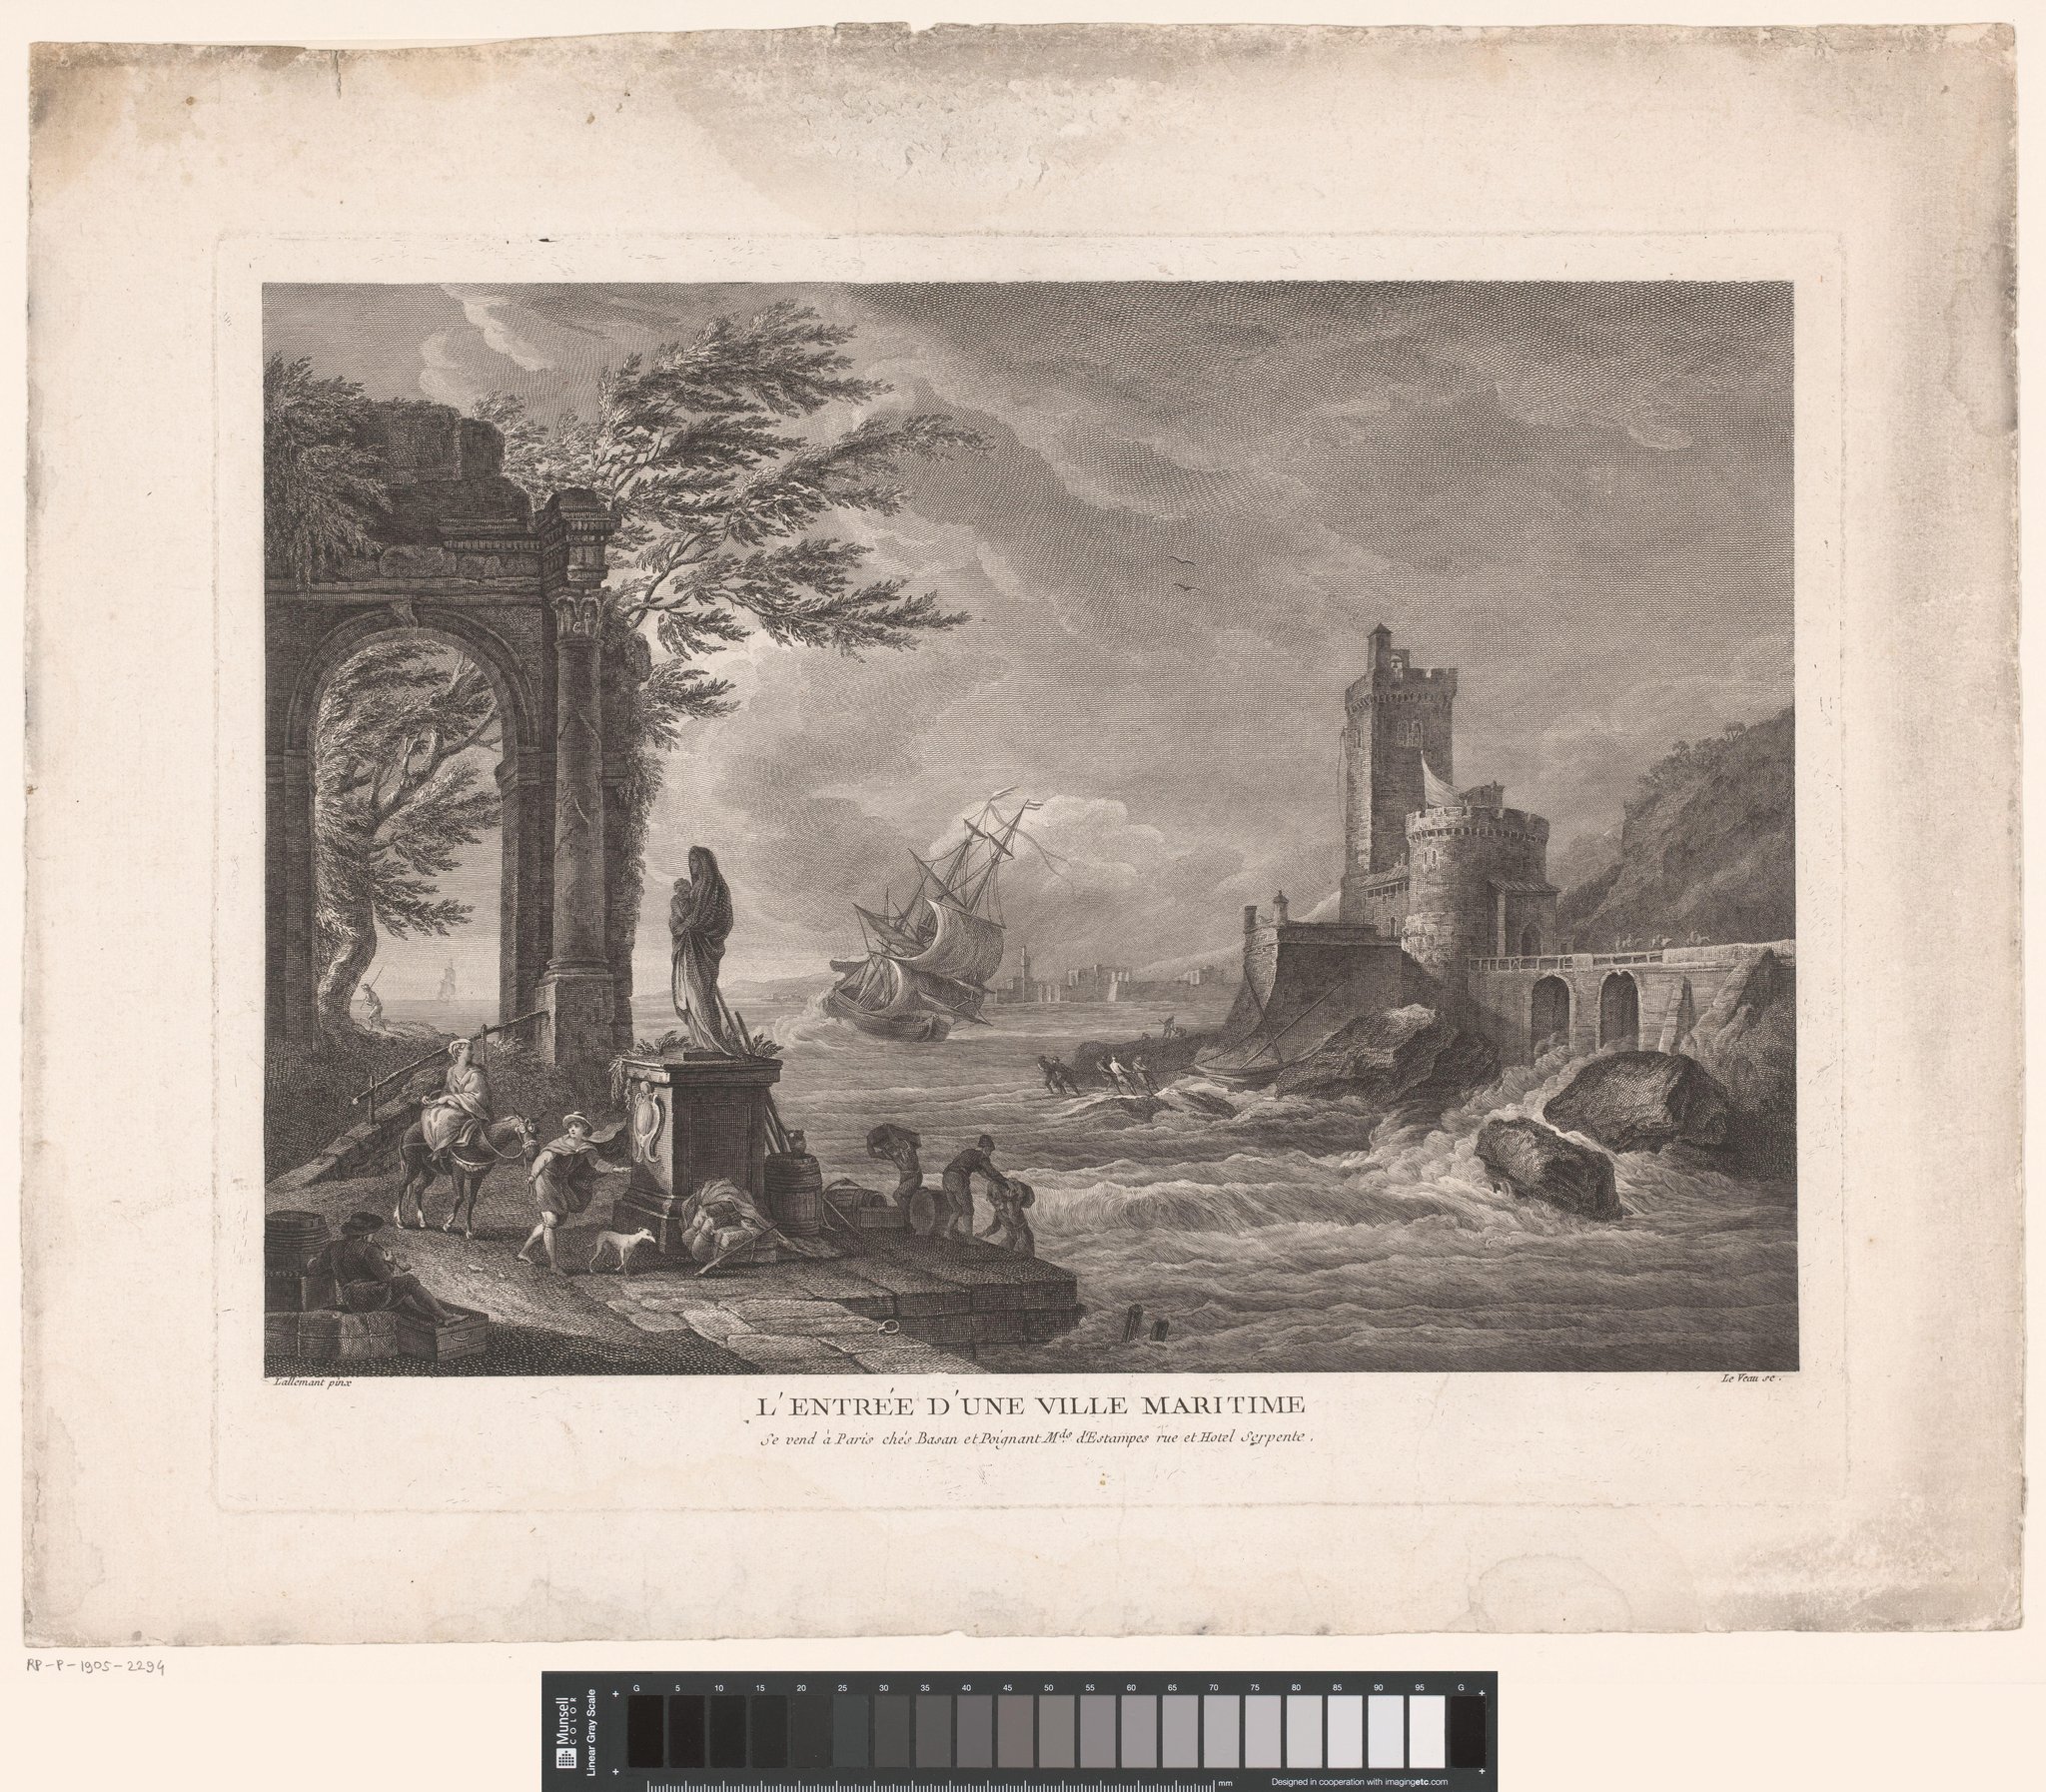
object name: print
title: L'entrée d'une ville maritime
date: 1739-1786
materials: paper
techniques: engraving, etching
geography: paris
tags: harbour, sailing-ship, sailing-boat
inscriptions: collector's mark: Lugt 2228